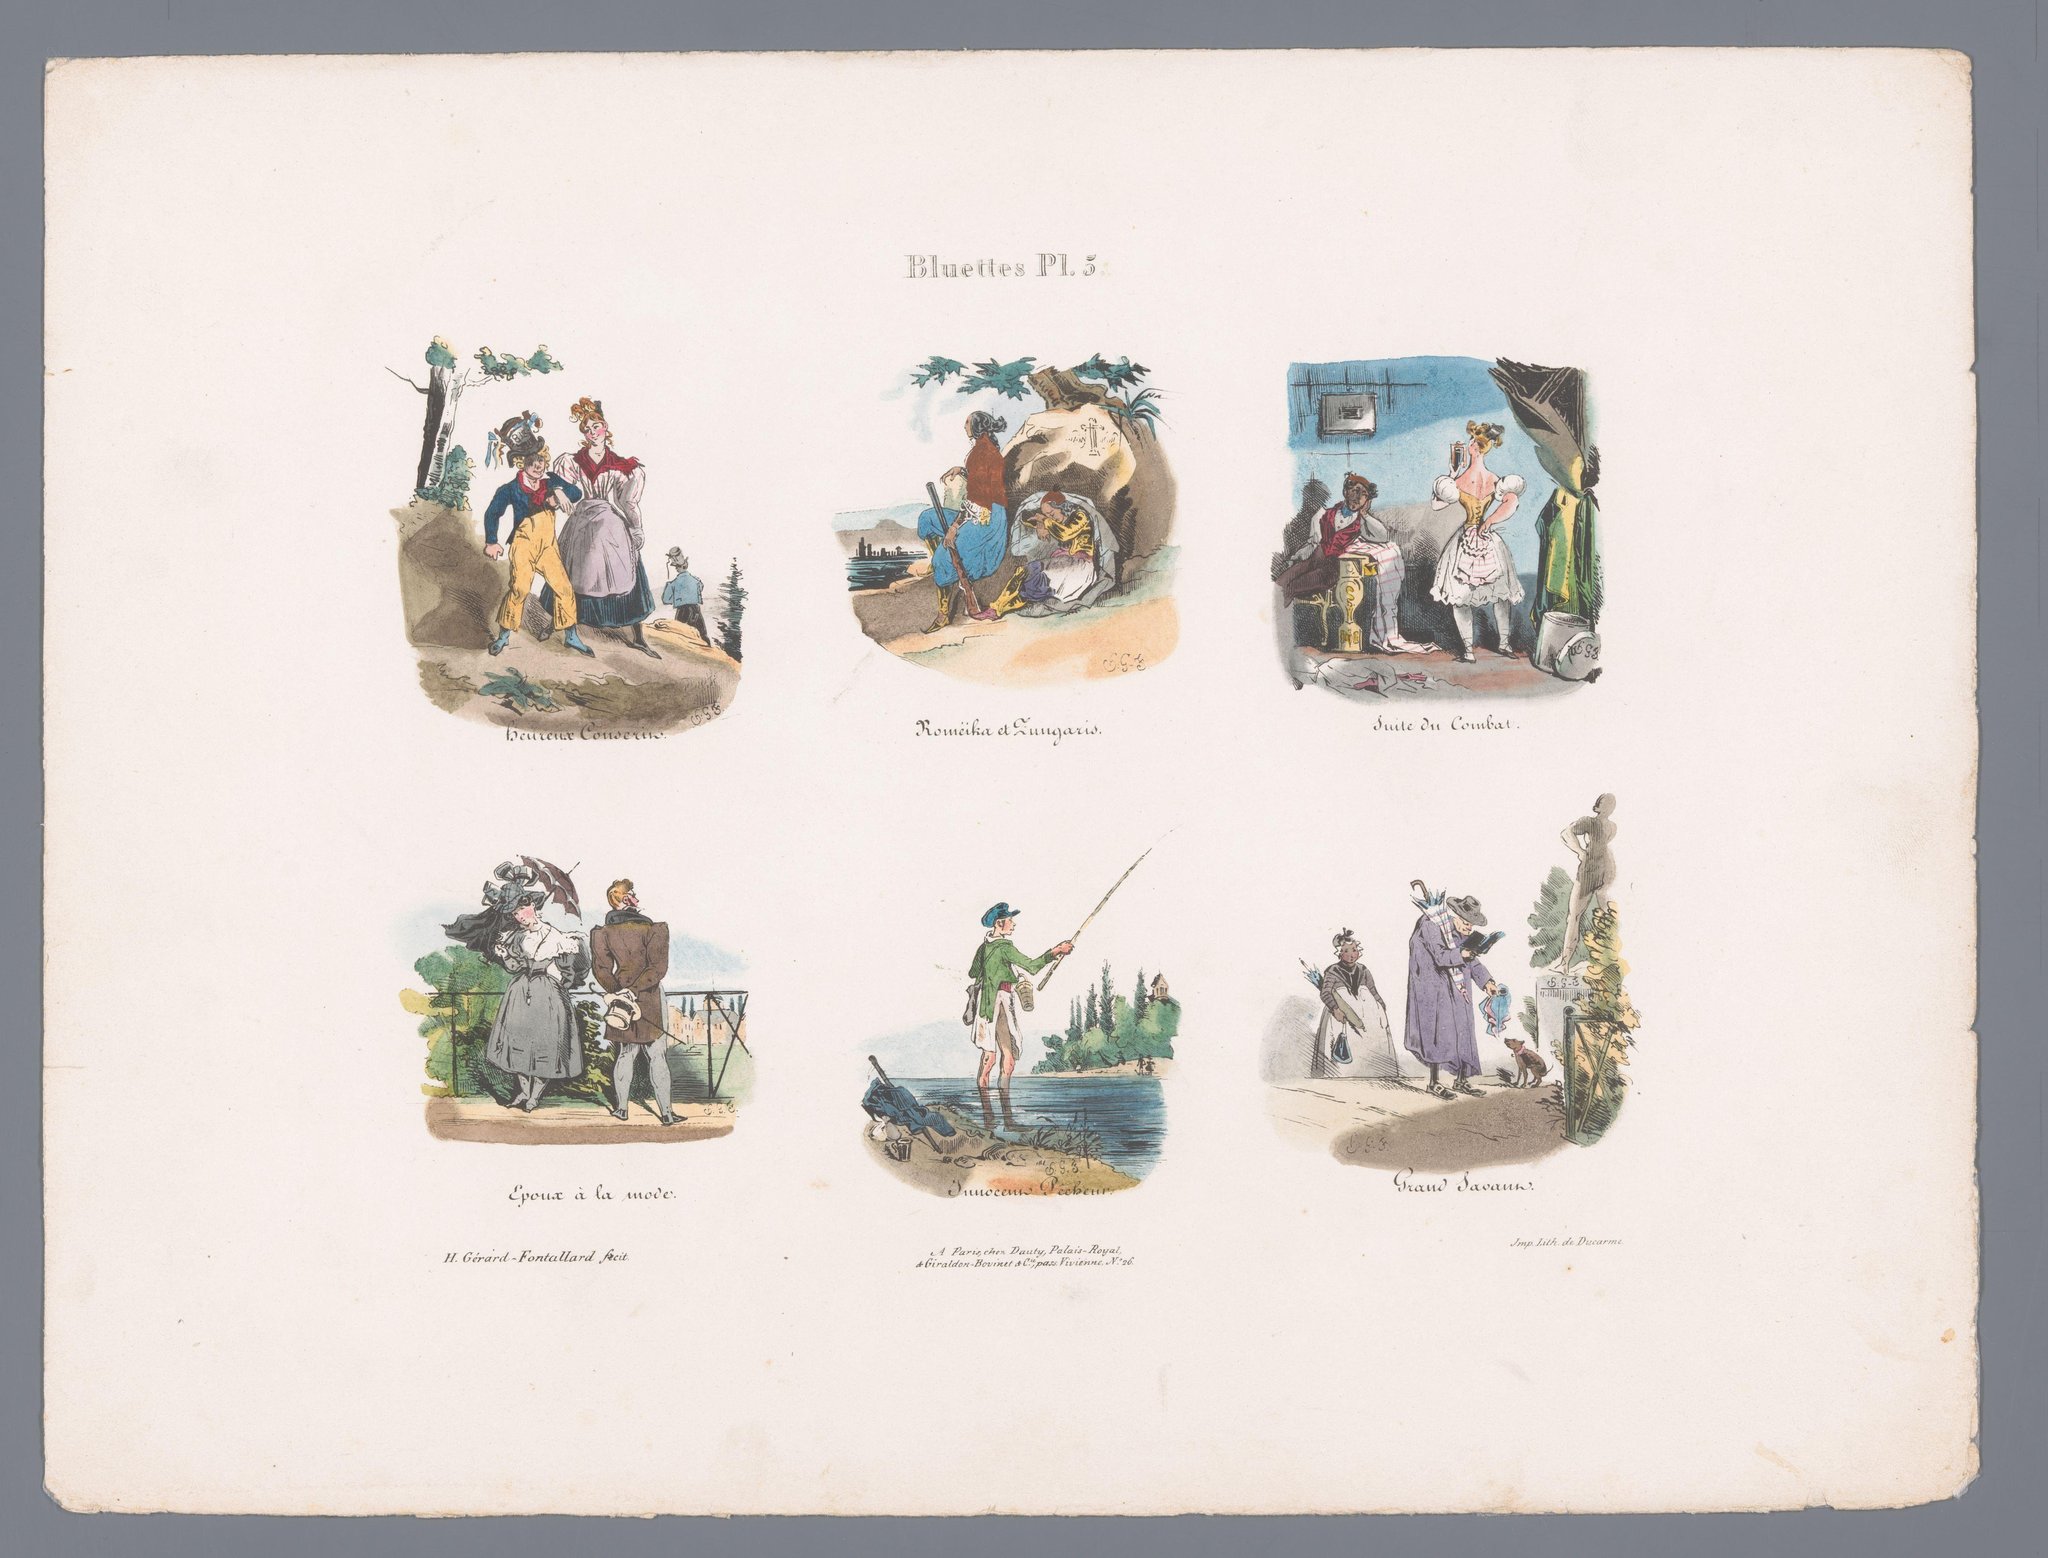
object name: print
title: Bluettes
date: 1828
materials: paper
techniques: hand coloring, lithograph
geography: paris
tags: various human types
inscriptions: collector's mark: Lugt 2228a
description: Prent maakt deel uit van een omslag met achttien prenten.